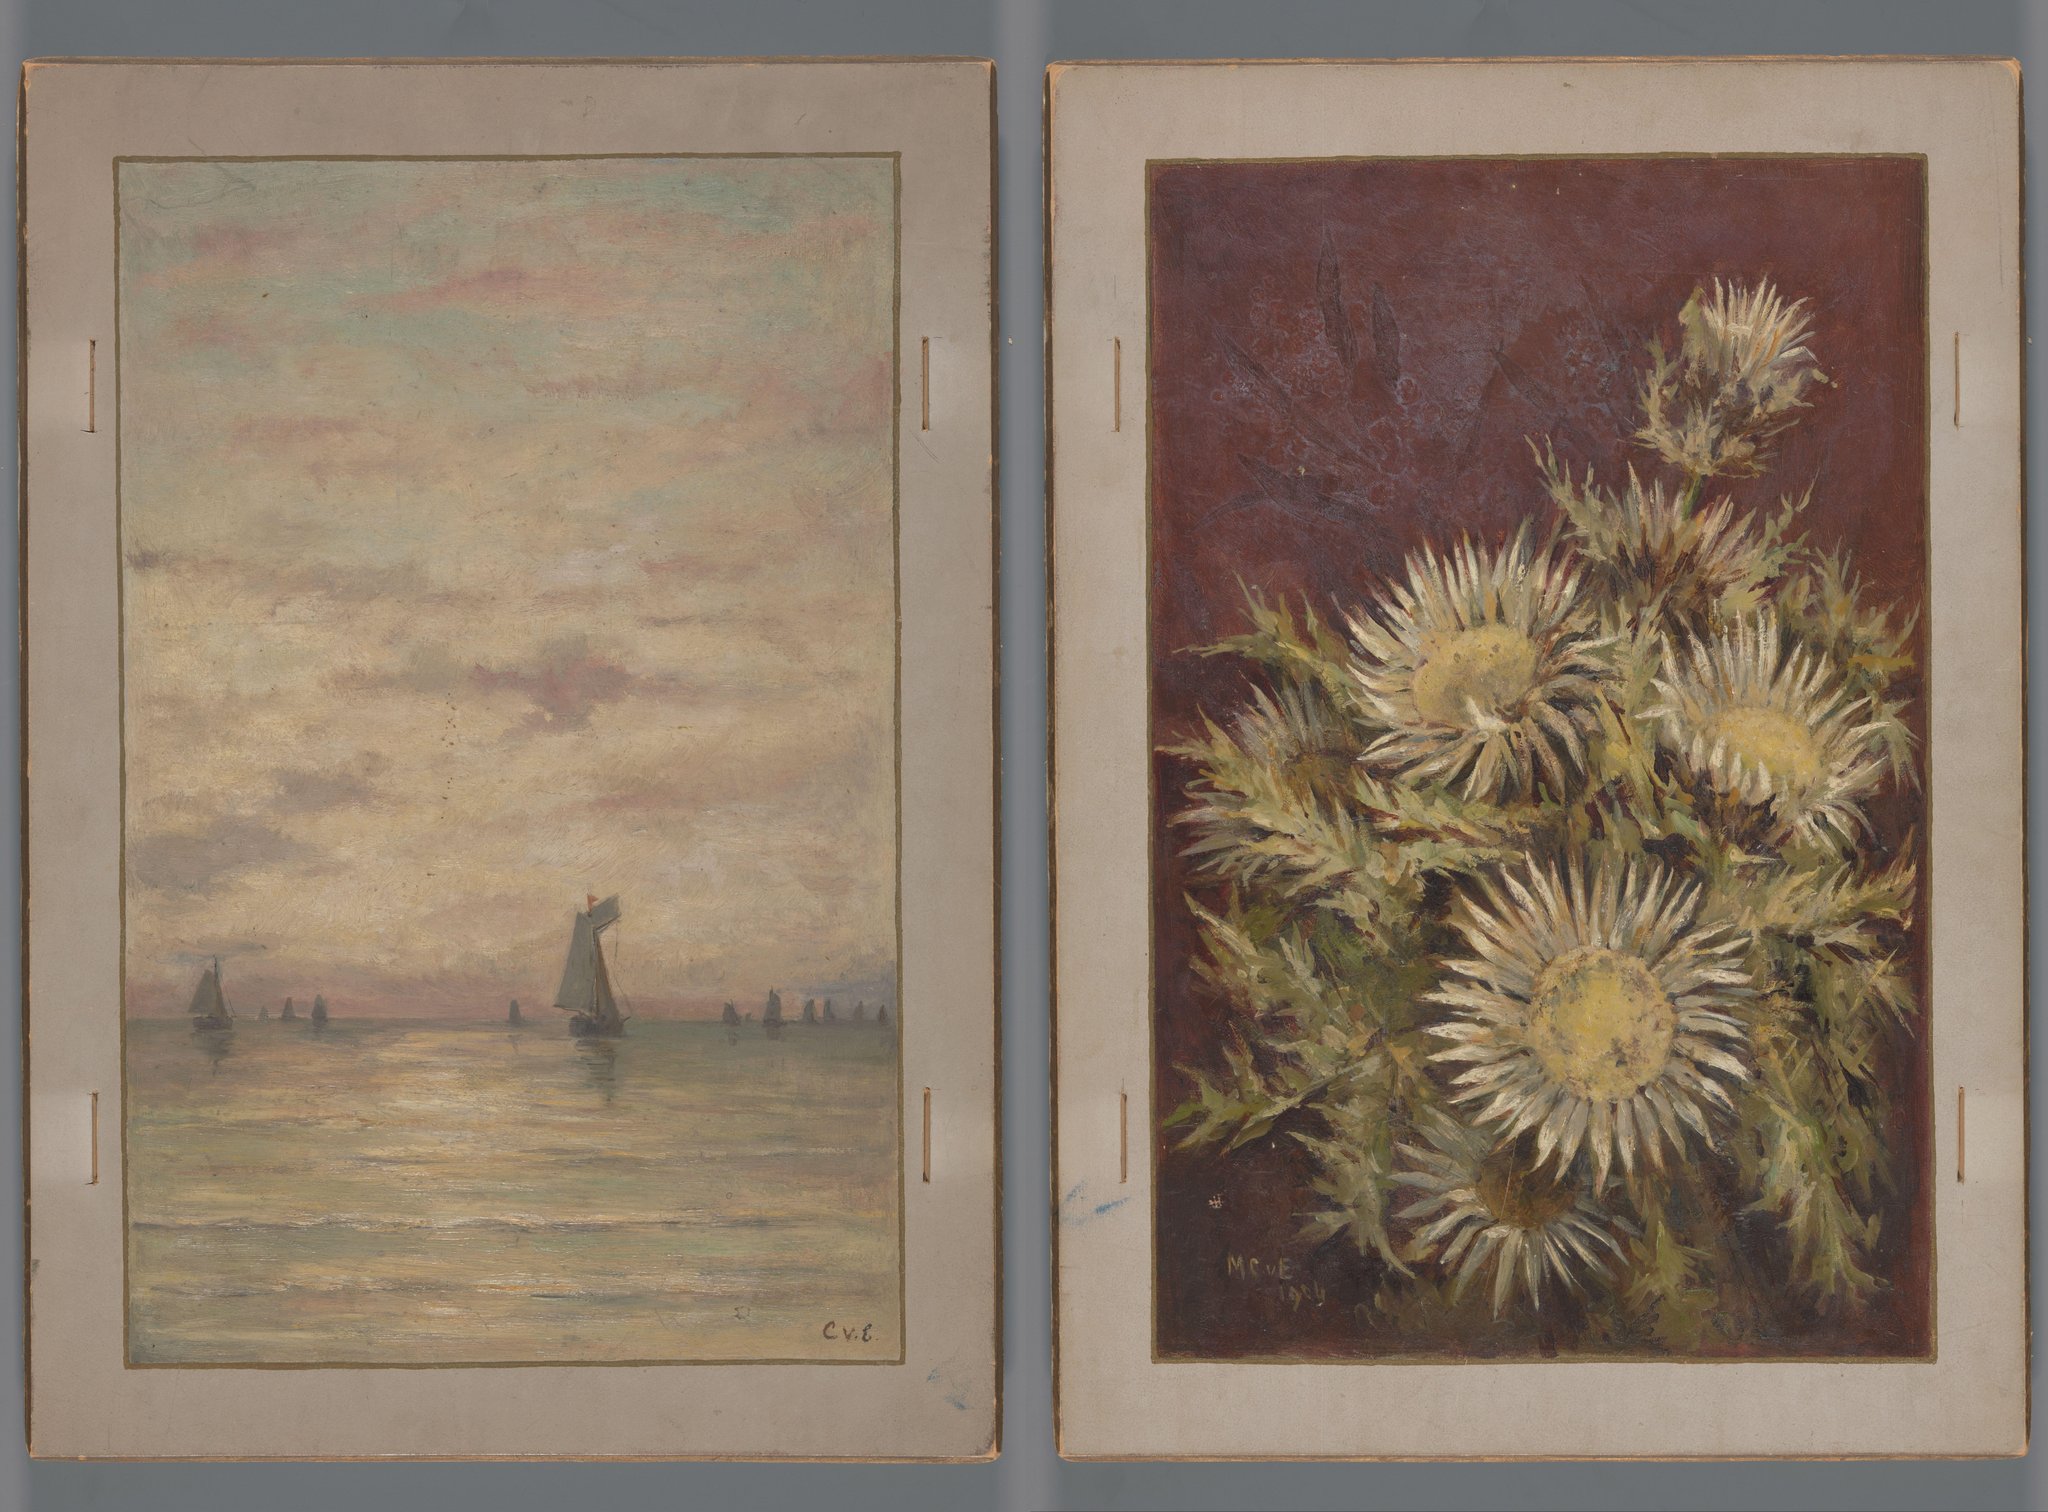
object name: folder container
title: Gezicht op water met zeilschepen en stilleven met zilverdistel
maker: anna catharina maria van eeghen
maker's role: draughtsman, print maker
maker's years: 1878-1924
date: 1904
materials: cardboard, paint, oil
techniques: brush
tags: sailing-ship, sailing-boat, landscapes with waters, waterscapes, seascapes (in the temperate zone)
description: Map voor tien bladen, waaronder een opdracht aan de schilder Maria Vos en negen bladen met tekeningen van planten en opgeplakte handtekeningen van inwoners van Oosterbeek, Gelderland.